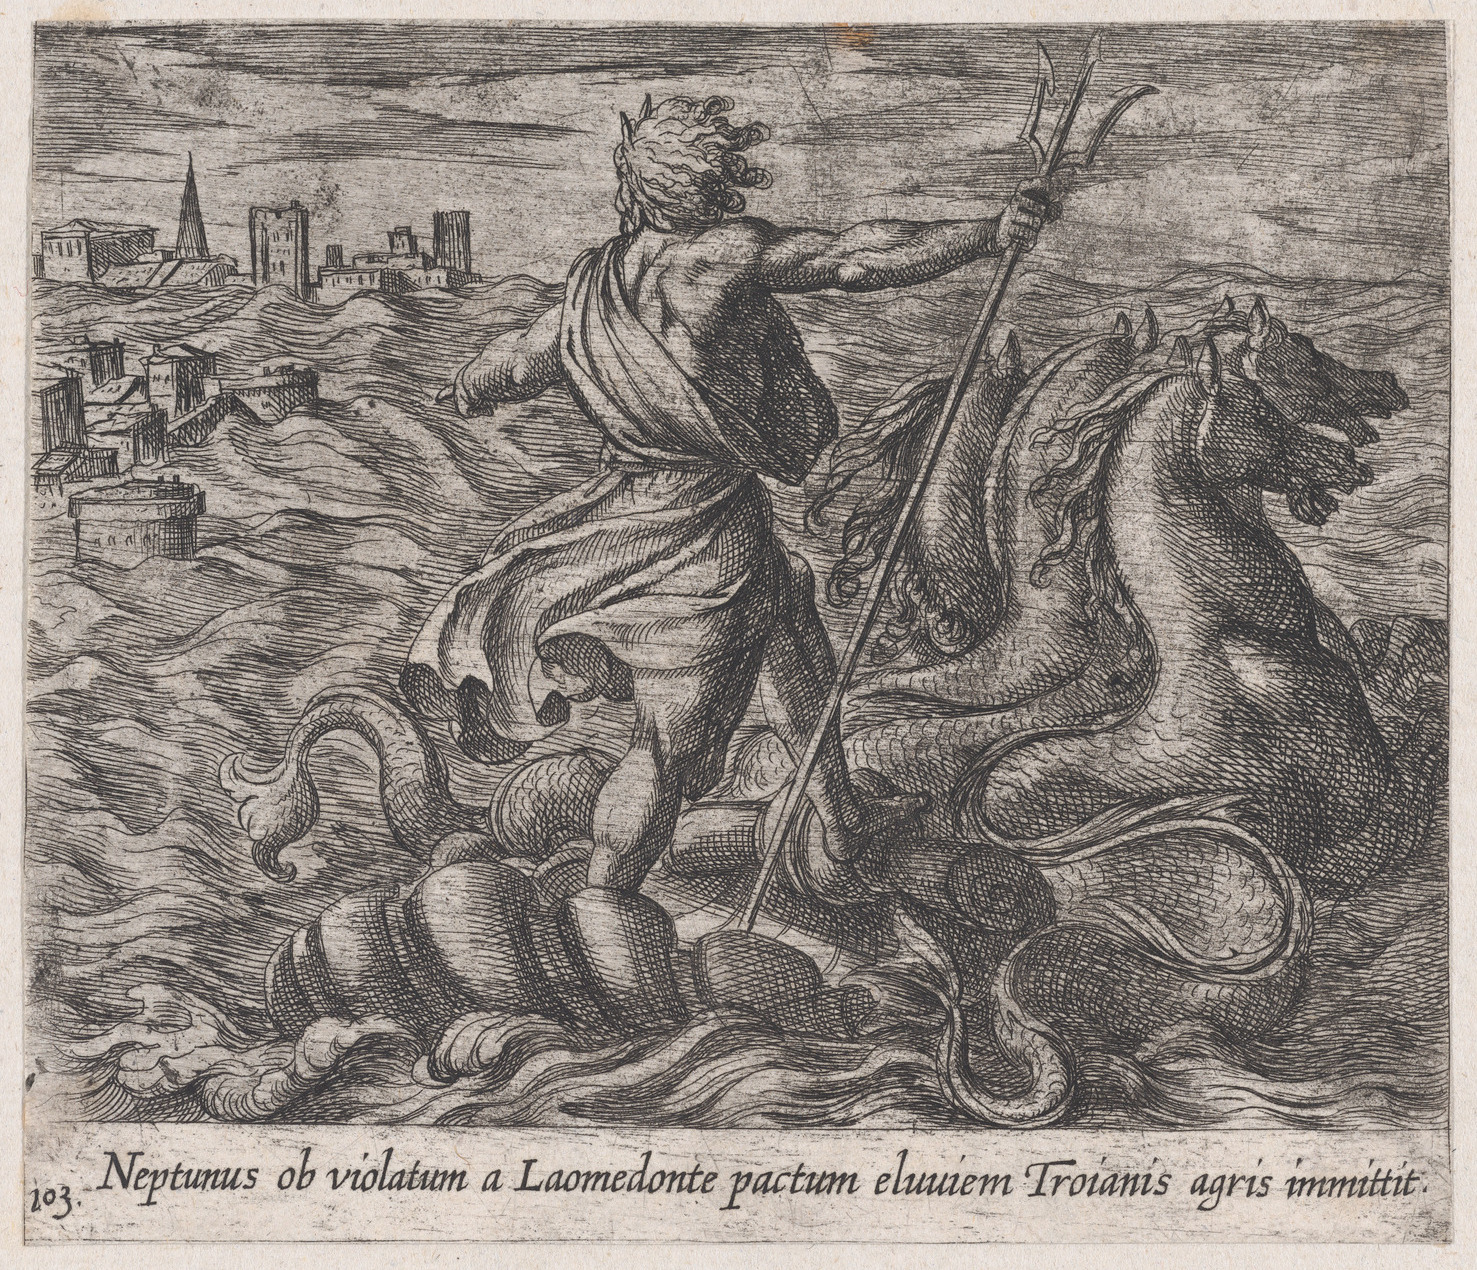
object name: print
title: Plate 103: Neptune Sending a Deluge to Troy (Neptunus ob violatum a Laomendonte pactum eluviem Troianis agris immittit), from Ovid's 'Metamorphoses'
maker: antonio tempesta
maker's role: artist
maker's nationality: italian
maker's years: 1555-1630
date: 1606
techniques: etching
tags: weapons,neptune